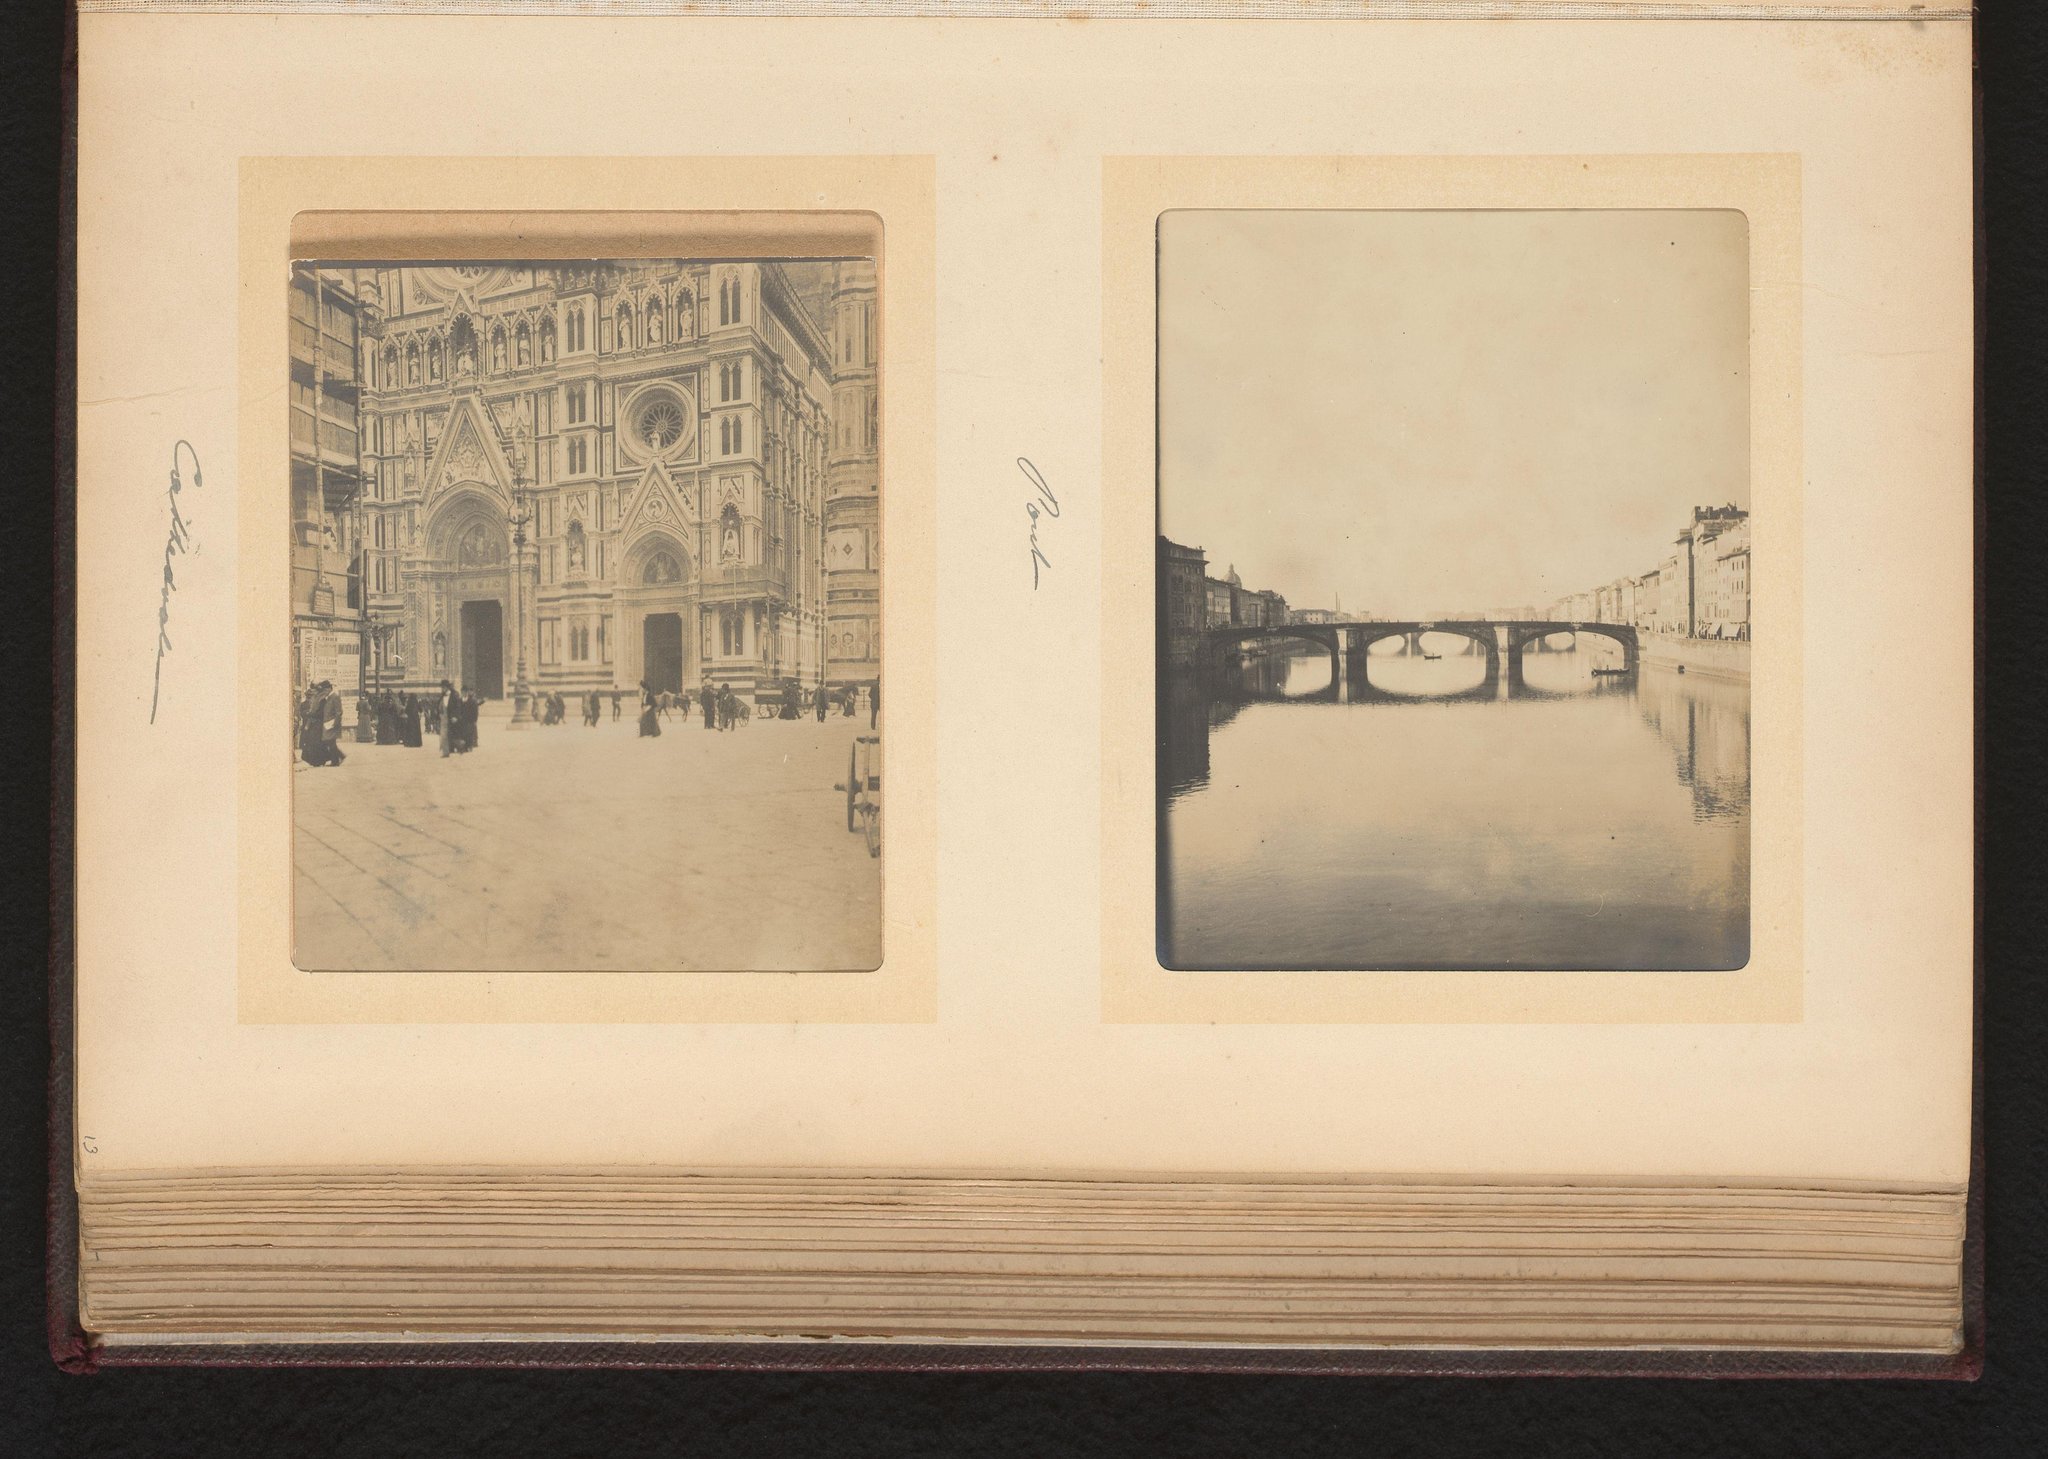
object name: album leaf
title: Brug en Duomo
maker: Anonymous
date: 1895-1905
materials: cardboard, photographic support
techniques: gelatin silver print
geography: florence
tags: tourism, church (exterior), bridge in city across river, canal, etc.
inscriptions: inscription: ‘Pont / Cathedrale’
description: Albumblad met twee foto's in Florence. Onderdeel van een fotoalbum van een reis door Italië, ca. 1900.